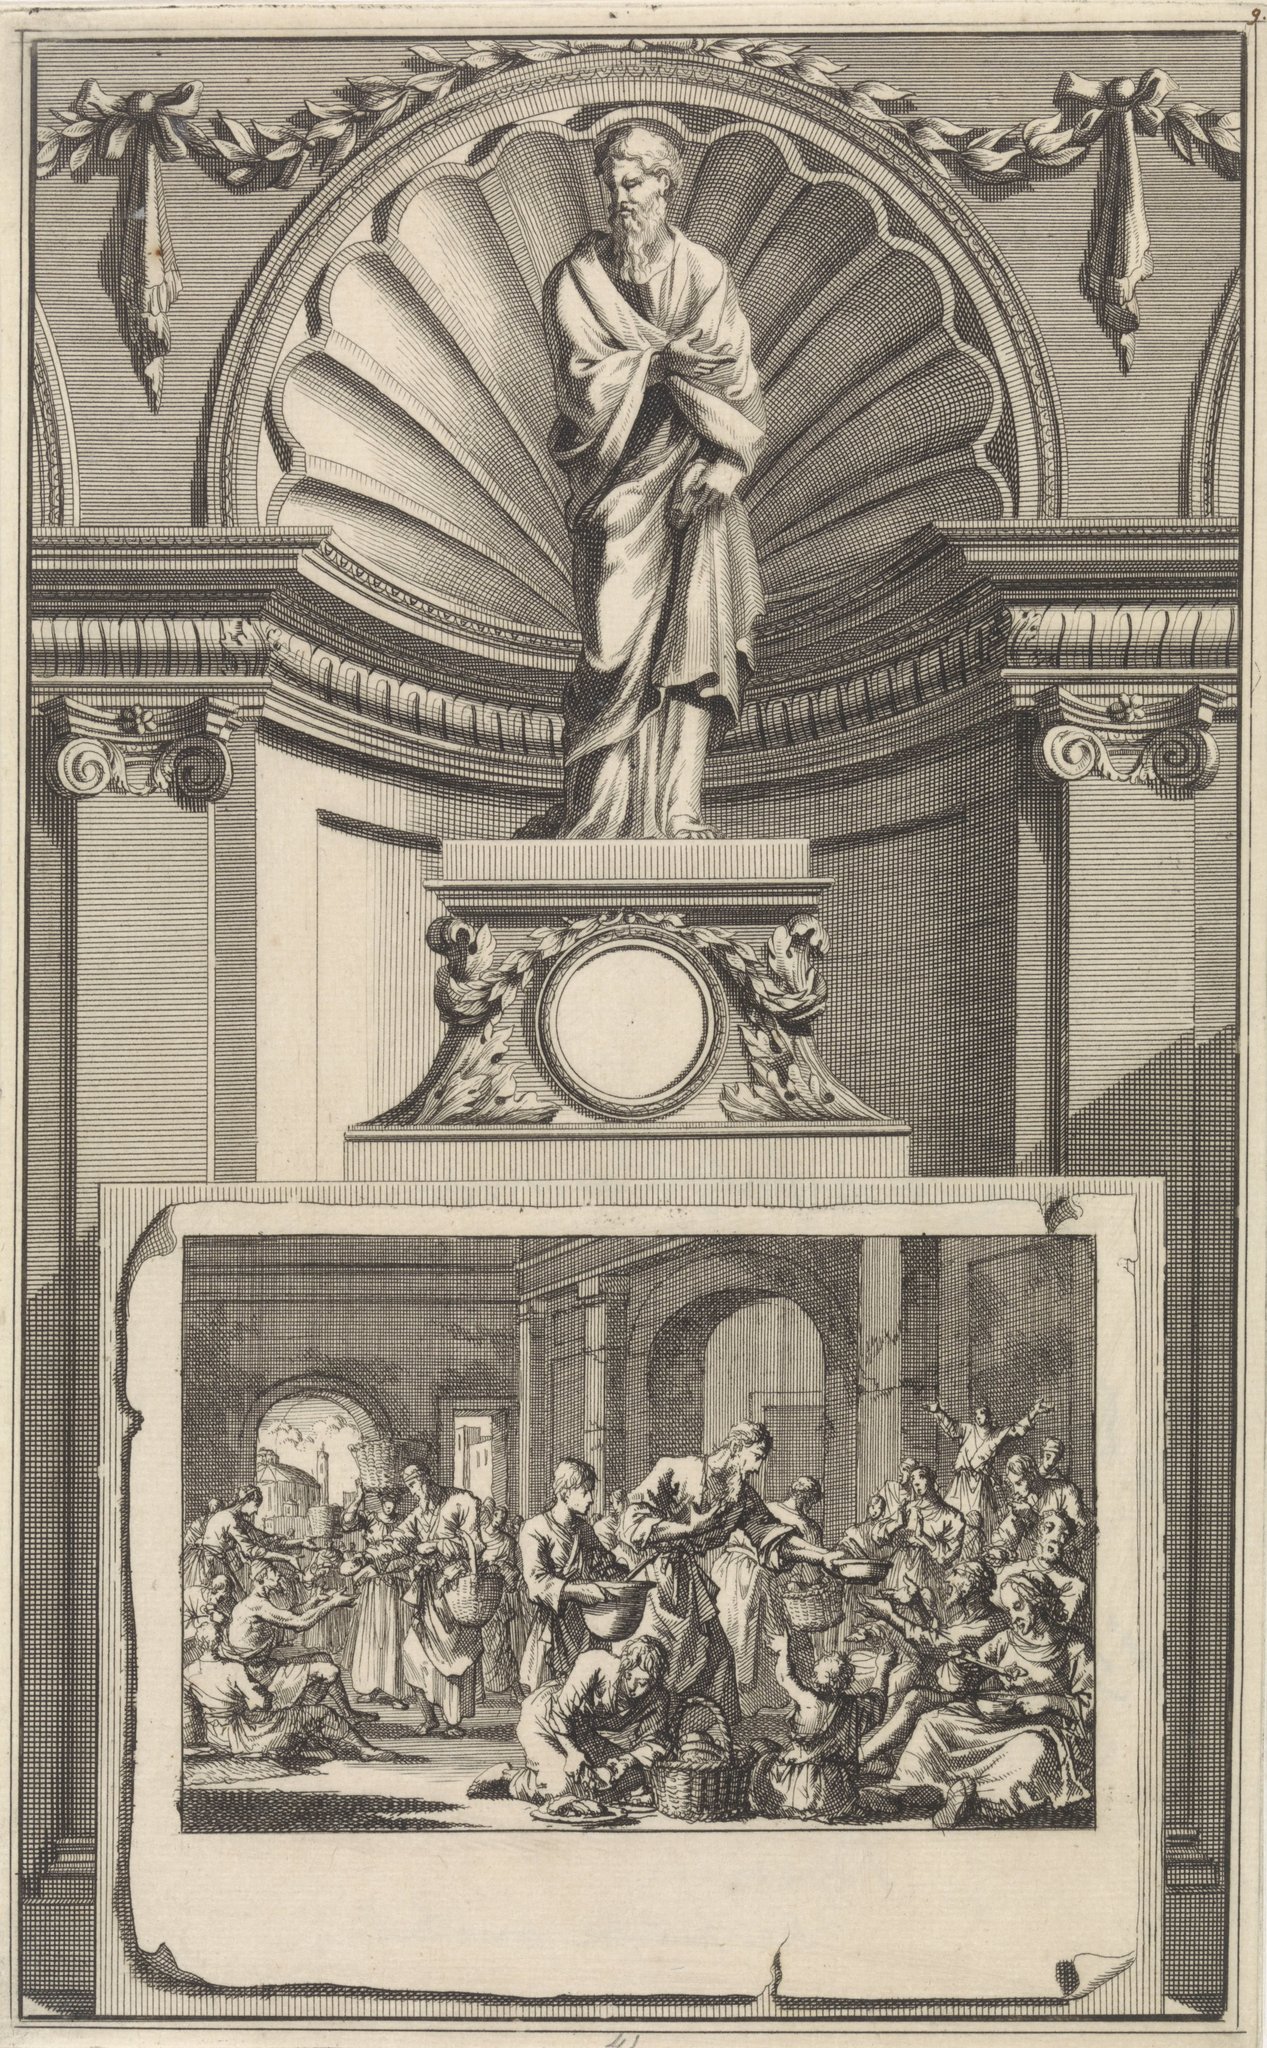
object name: print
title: H. Basilius van Caesarea, kerkvader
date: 1698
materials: paper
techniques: engraving, etching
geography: amsterdam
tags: giving alms or other charity, e.g.: handing out food, basil the great (basilius magnus), bishop of caesarea; possible attributes: dove, (column of) fire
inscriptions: number: ‘9’, collector's mark: Lugt 2228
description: Proefdruk van illustratie uit: Cave, William. Apostolische oudheden, of Het leven (...) der heylige apostelen, 3 delen. Utrecht: François Halma en Willem van de Water (I), 1698, p. 311.